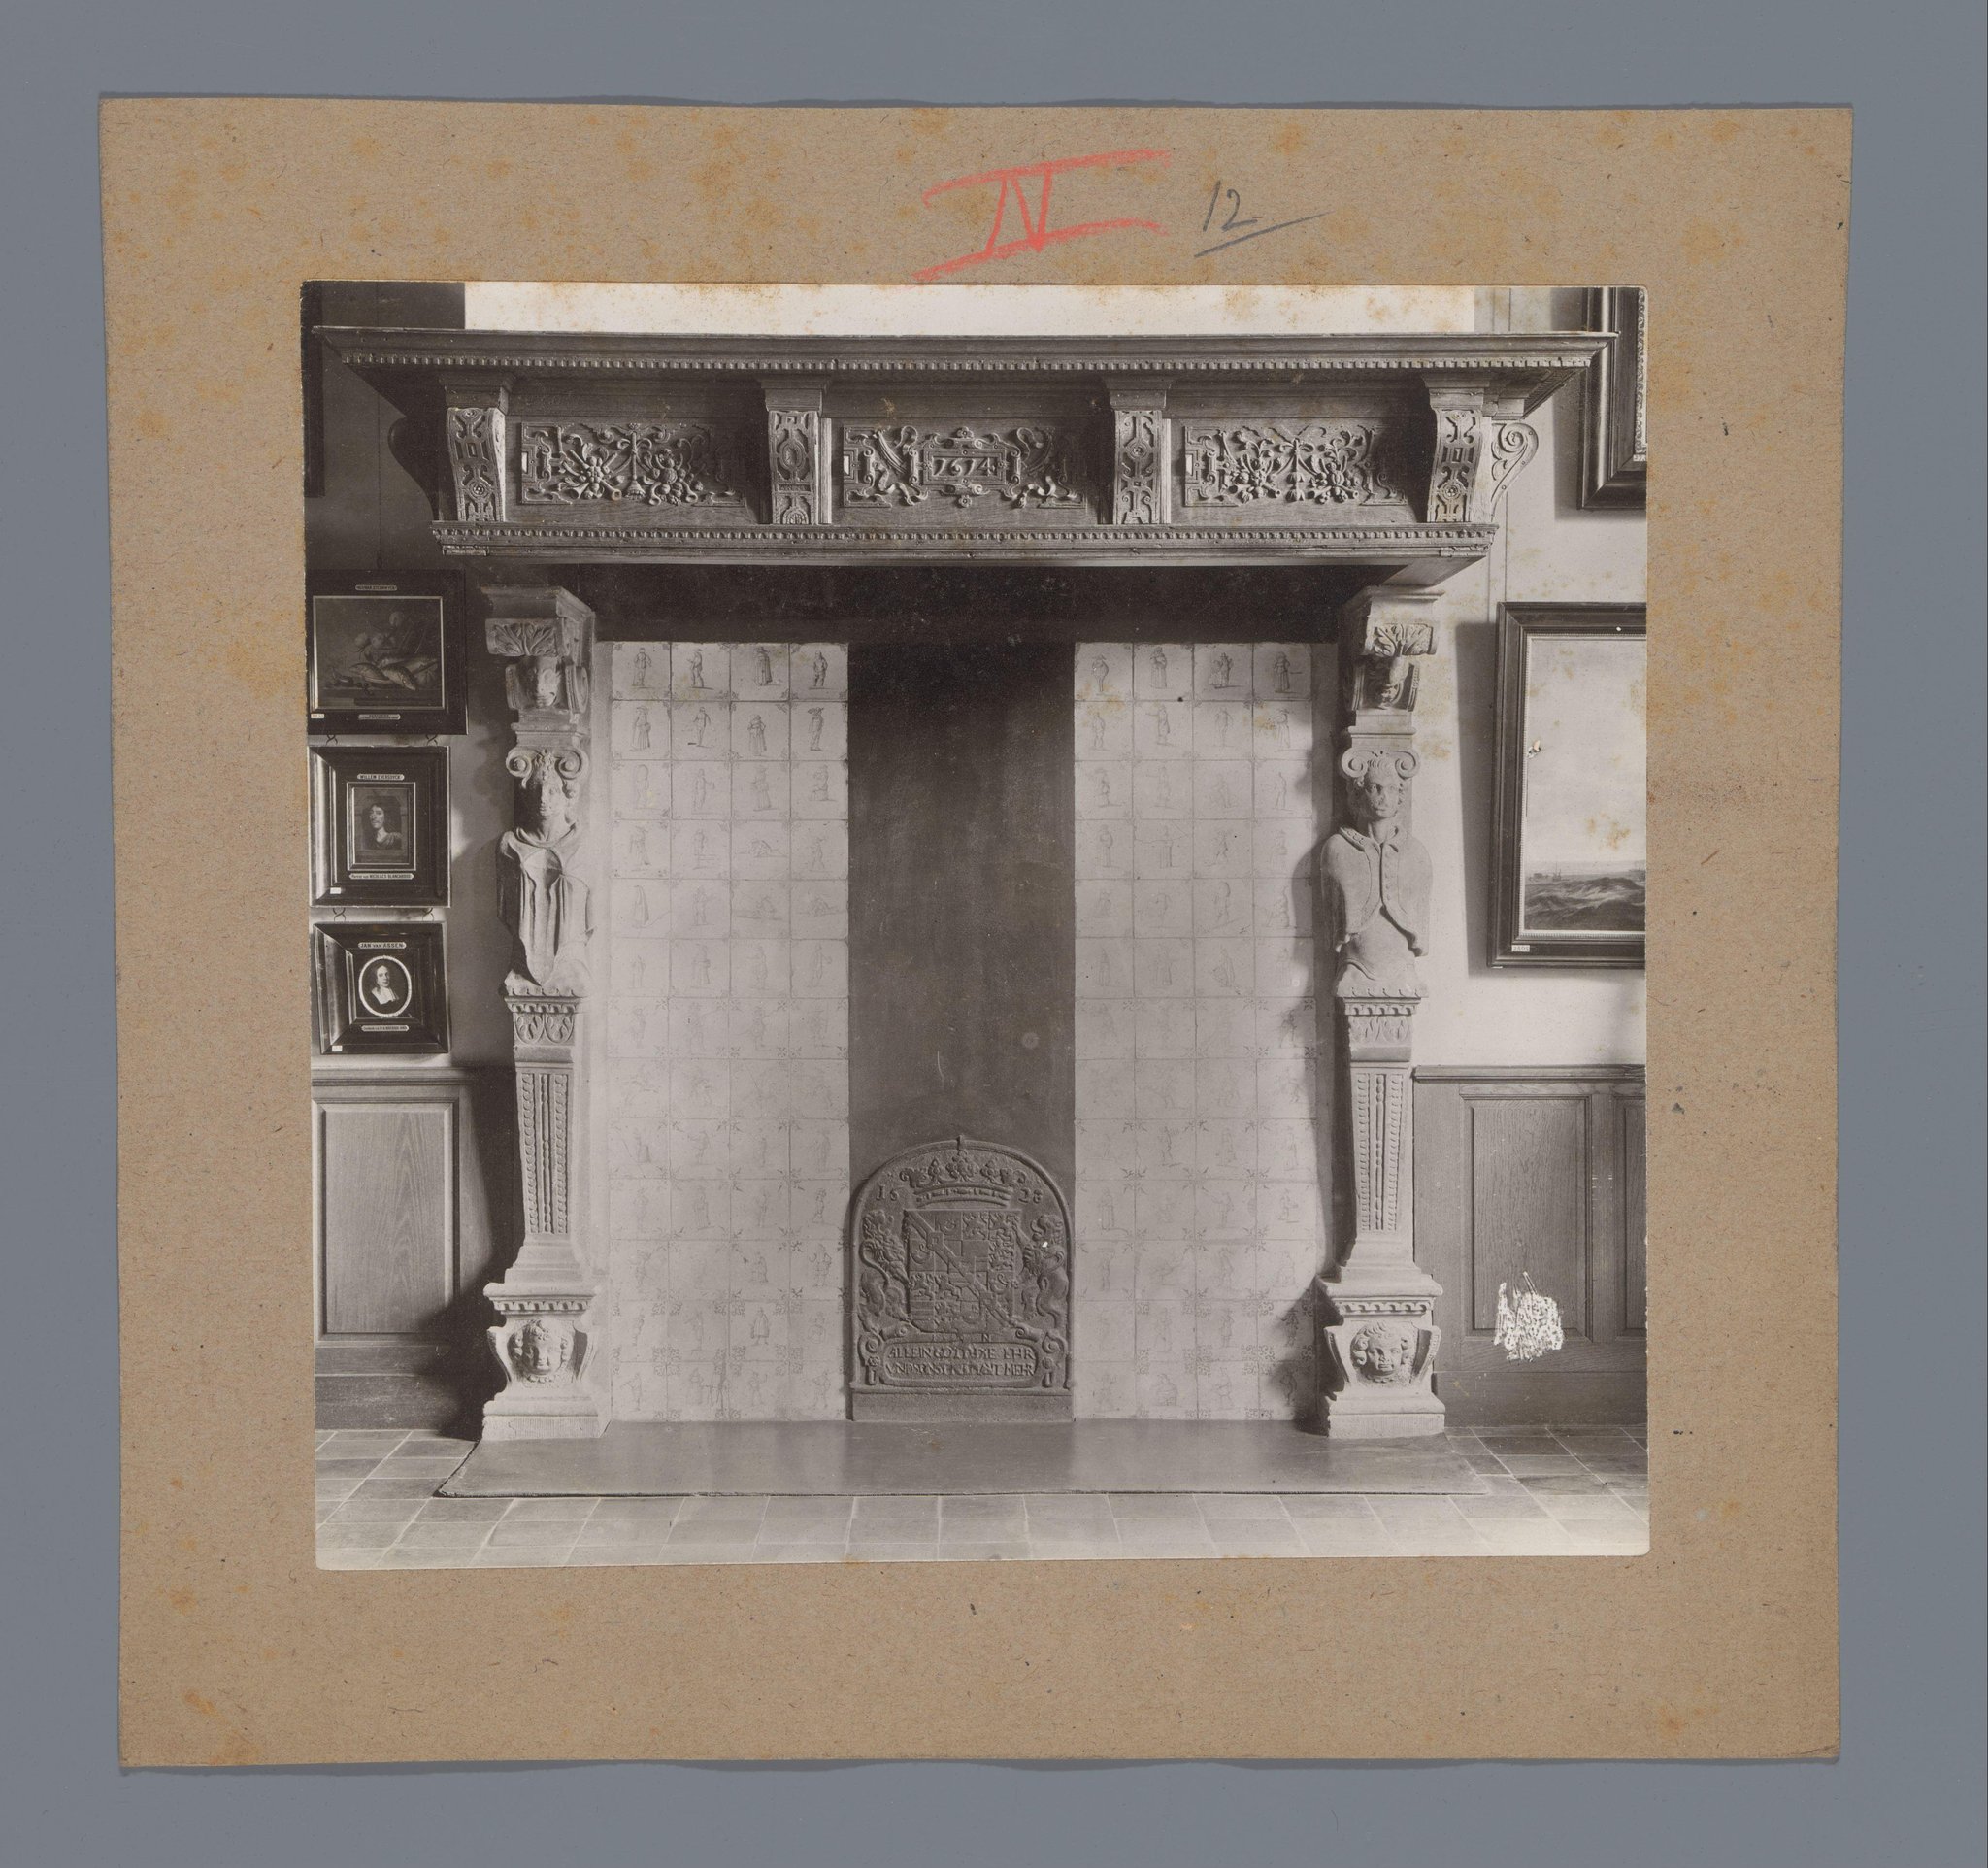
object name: photograph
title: Schoorsteenmantel in het Rijksmuseum te Amsterdam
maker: Anonymous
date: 1875-1900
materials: photographic support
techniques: carbon print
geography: amsterdam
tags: open hearth, fire-place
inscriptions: collector's mark: ‘Kunstnijverheidschool Quellinus Amsterdam Frans Halsstraat 14.’, collector's mark: ‘Instituut voor kunst-nijverheidsonderwijs Gabriël Metsustraat No. 16, Amsterdam’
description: Zie voor het originele object SK-A-4486.